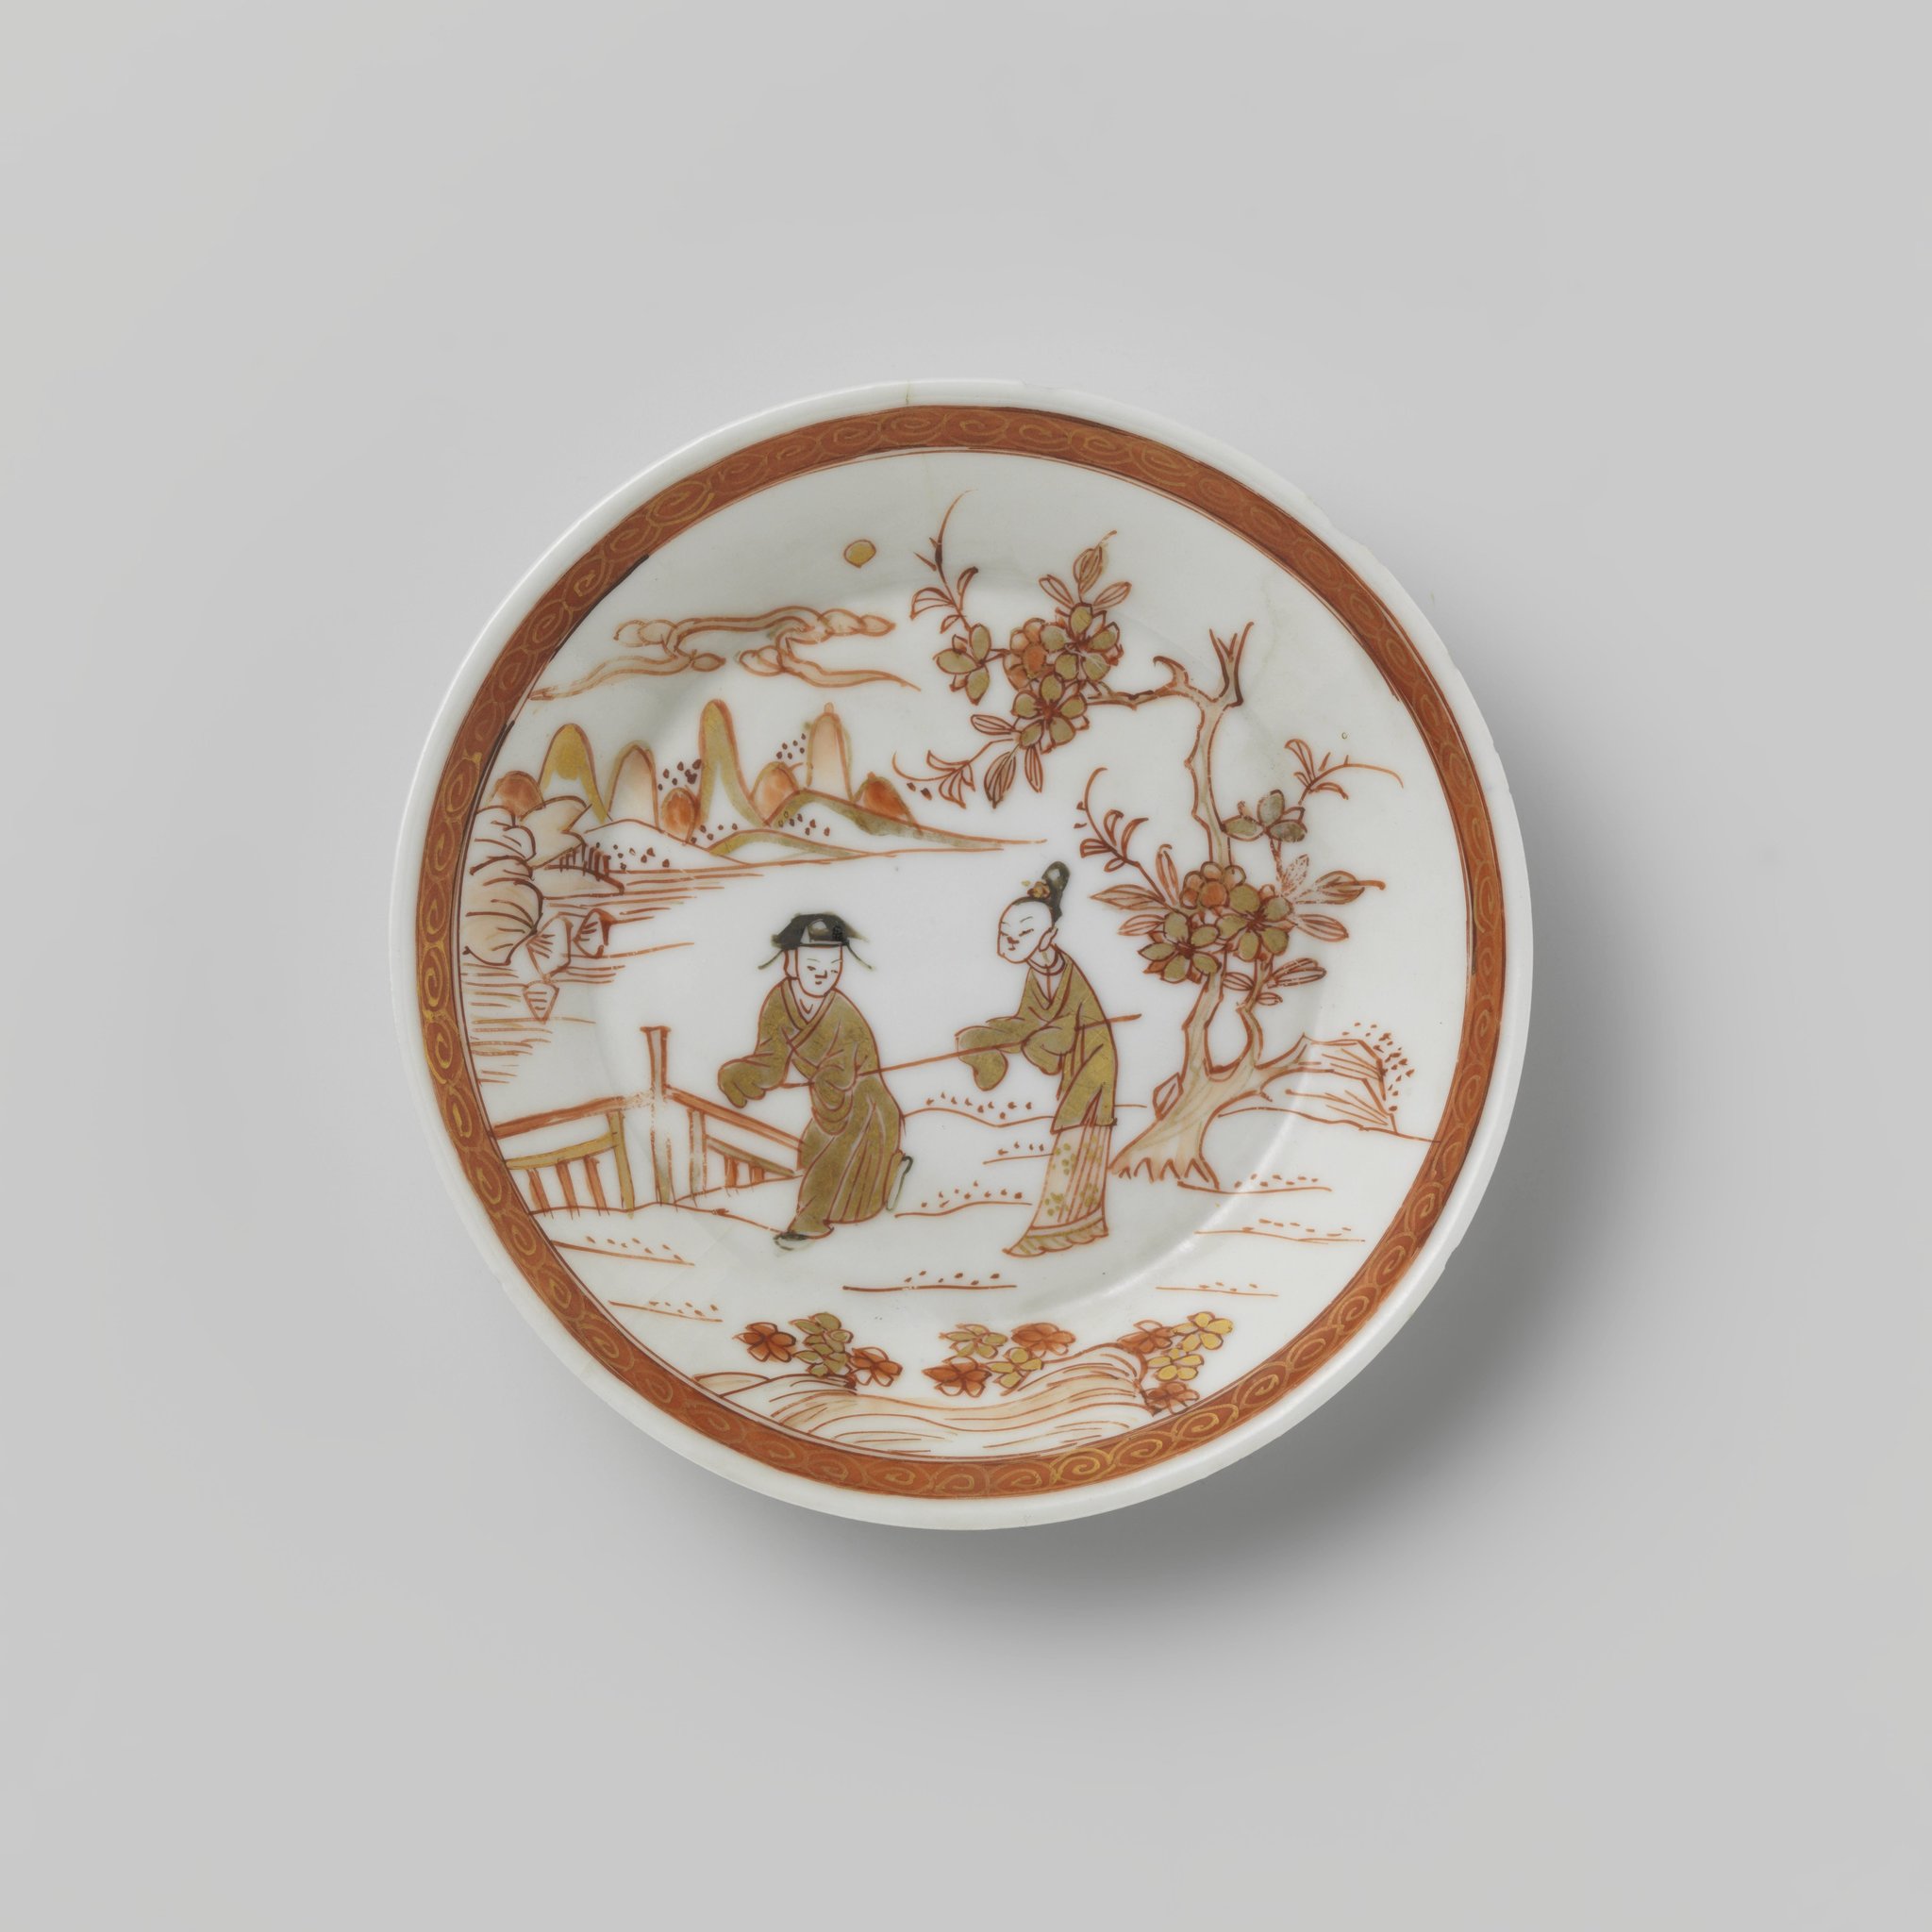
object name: kop en schotel, kop en schotel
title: Saucer with two figures in a water landscape and a flowering tree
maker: Anonymous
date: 1700-1724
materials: glaze, gold, paint, porcelain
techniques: firing, gilding, turning, vitrification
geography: china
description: Schotel van porselein met rechte wand, beschilderd op het glazuur in rood, zwart en goud. Op het plat van de schotel twee personen naast een bloeiende boom en een hek in een rivierlandschap; de rand met krulwerk. Melk en bloed.